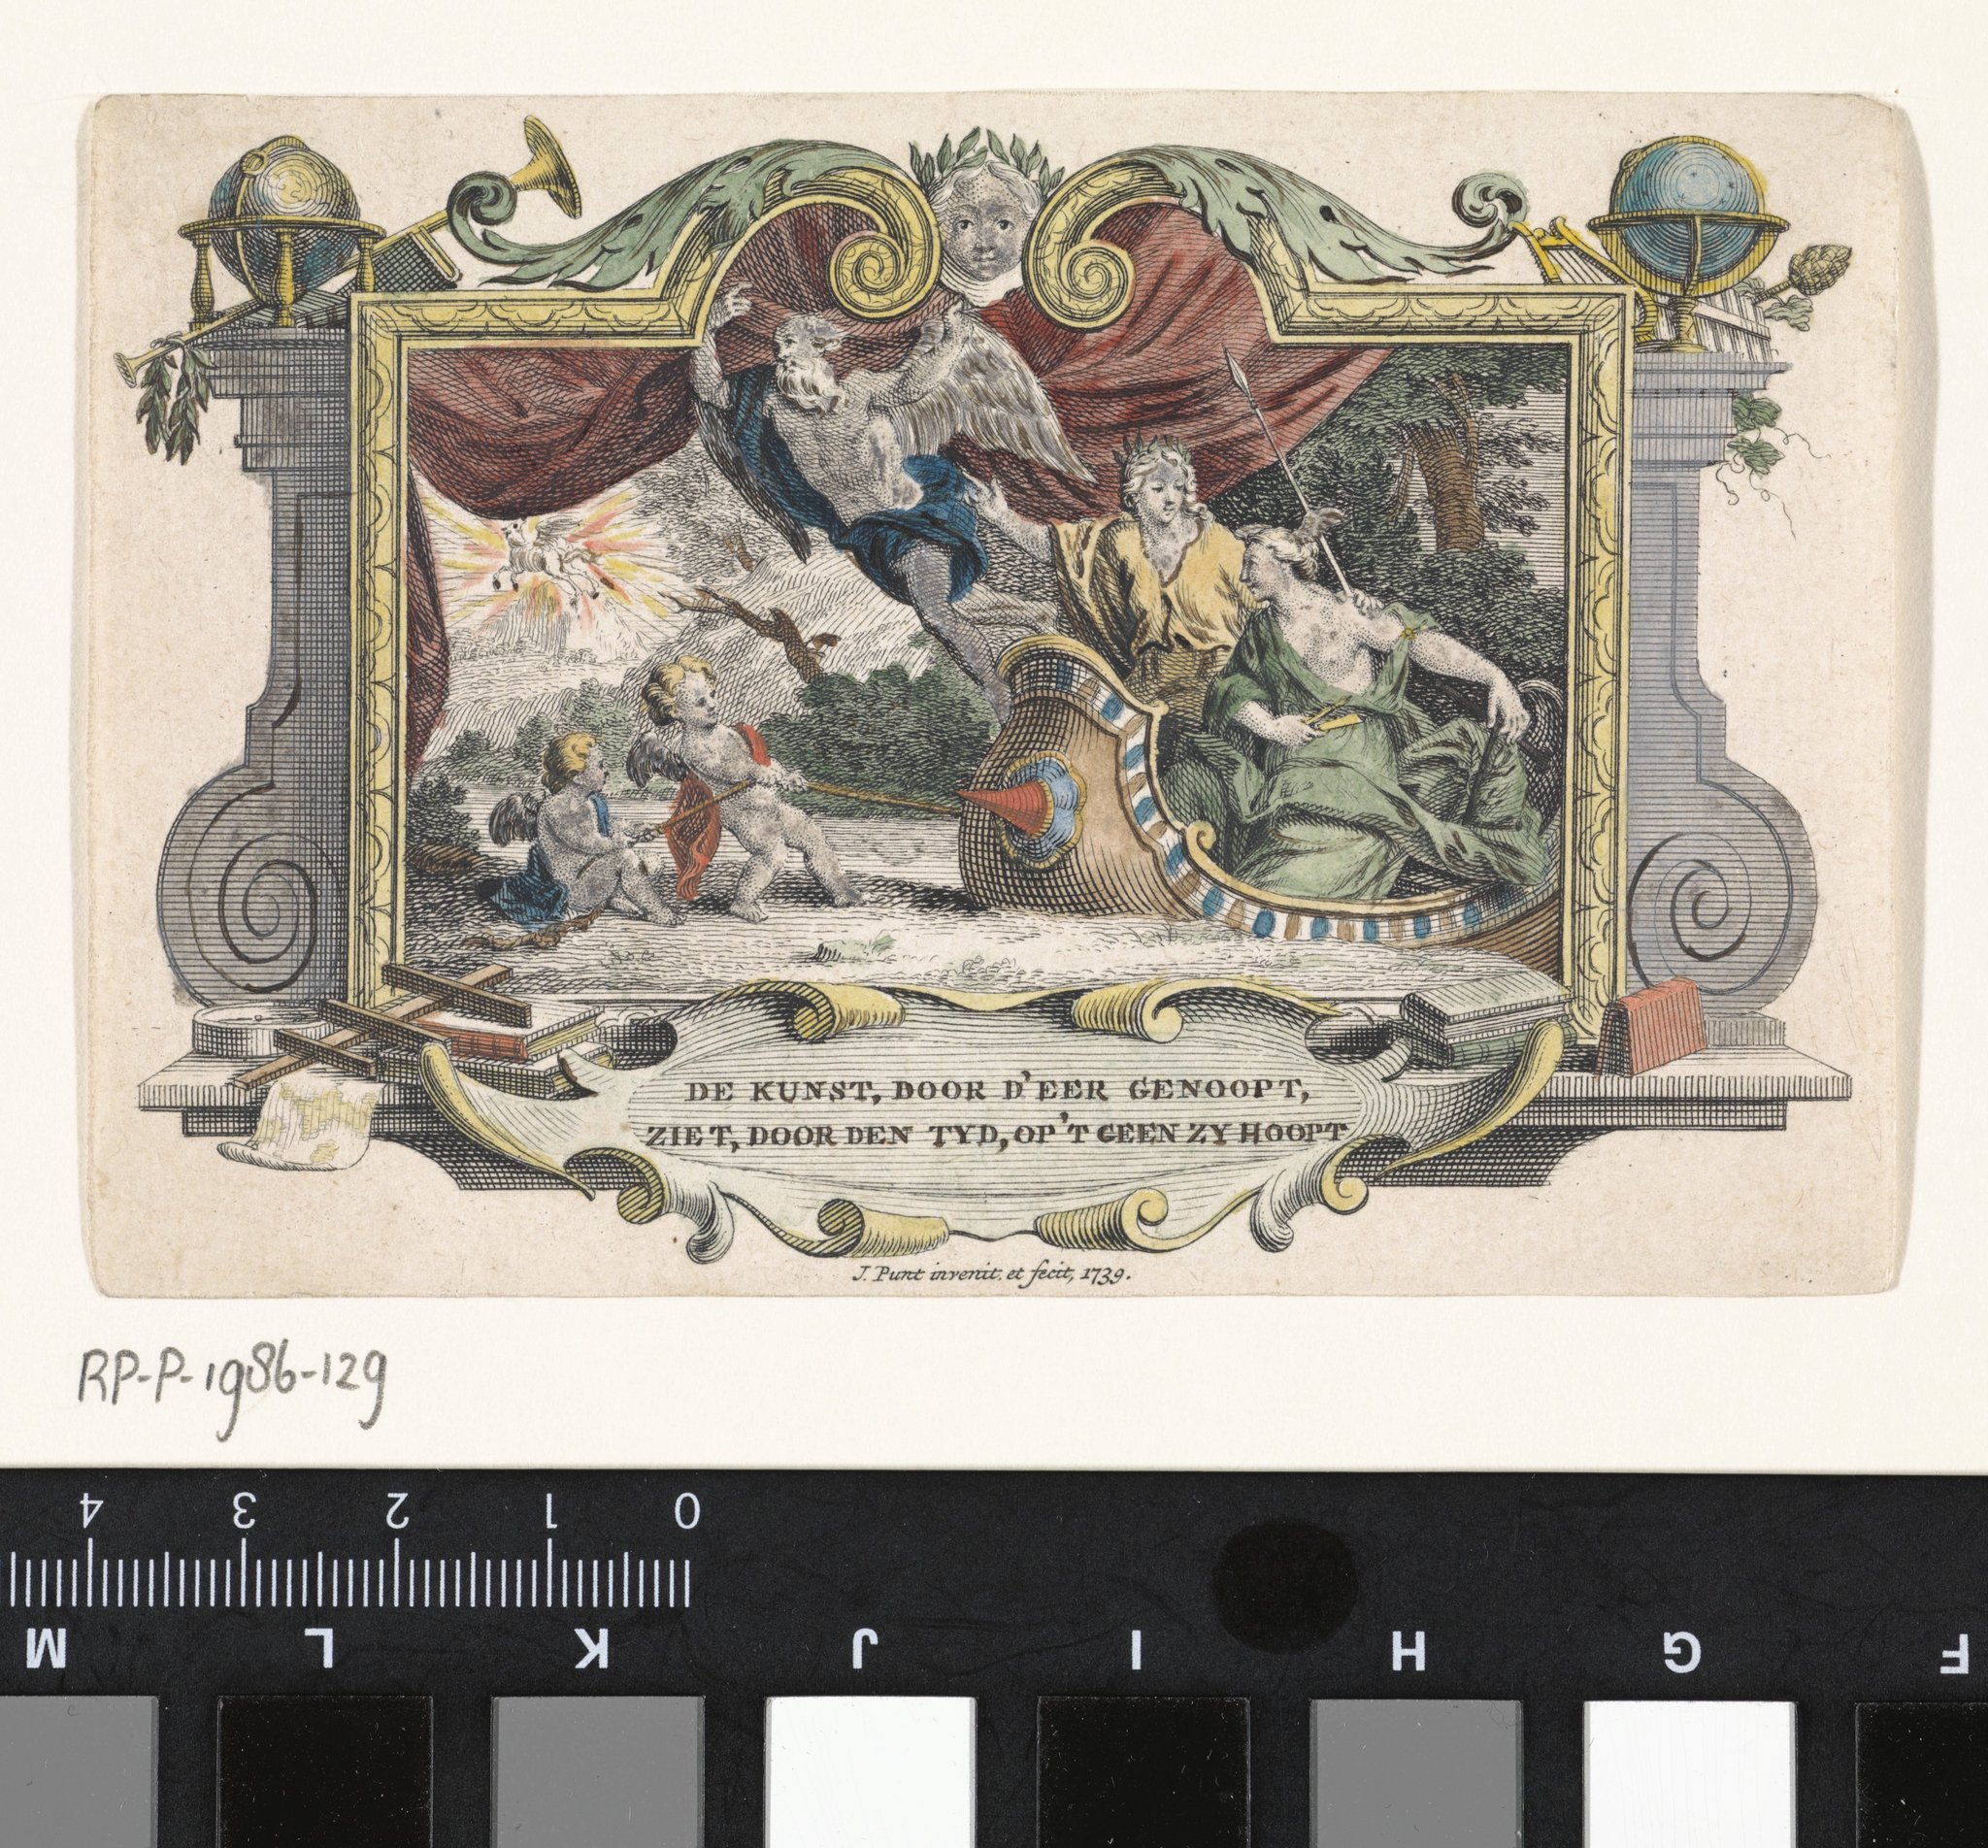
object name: print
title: Personificaties van Eer en Kunst in een roeiboot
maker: jan punt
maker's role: draughtsman, print maker, publisher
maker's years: 1711-1779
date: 1739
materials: paper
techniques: engraving, etching, hand coloring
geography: amsterdam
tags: pegasus, the winged horse, symbolic representations, allegories and emblems ~ art; 'arte' (ripa), father time, man with wings and scythe, honour, glory; 'ampiezza della gloria', 'gloria', 'gloria de prencipi', 'gloria & honore', 'honore', 'sublimatà della gloria' (ripa)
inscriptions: collector's mark: Lugt 2760, collector's mark: Lugt 2228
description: Twee putti trekken de boot waarin Eer en Kunst zitten op de oever. Eer wijst Kunst op Vader Tijd die in de lucht vliegt. Op de achtergrond vliegt Pegasus. De voorstelling is gevat in een ornamentele omlijsting.